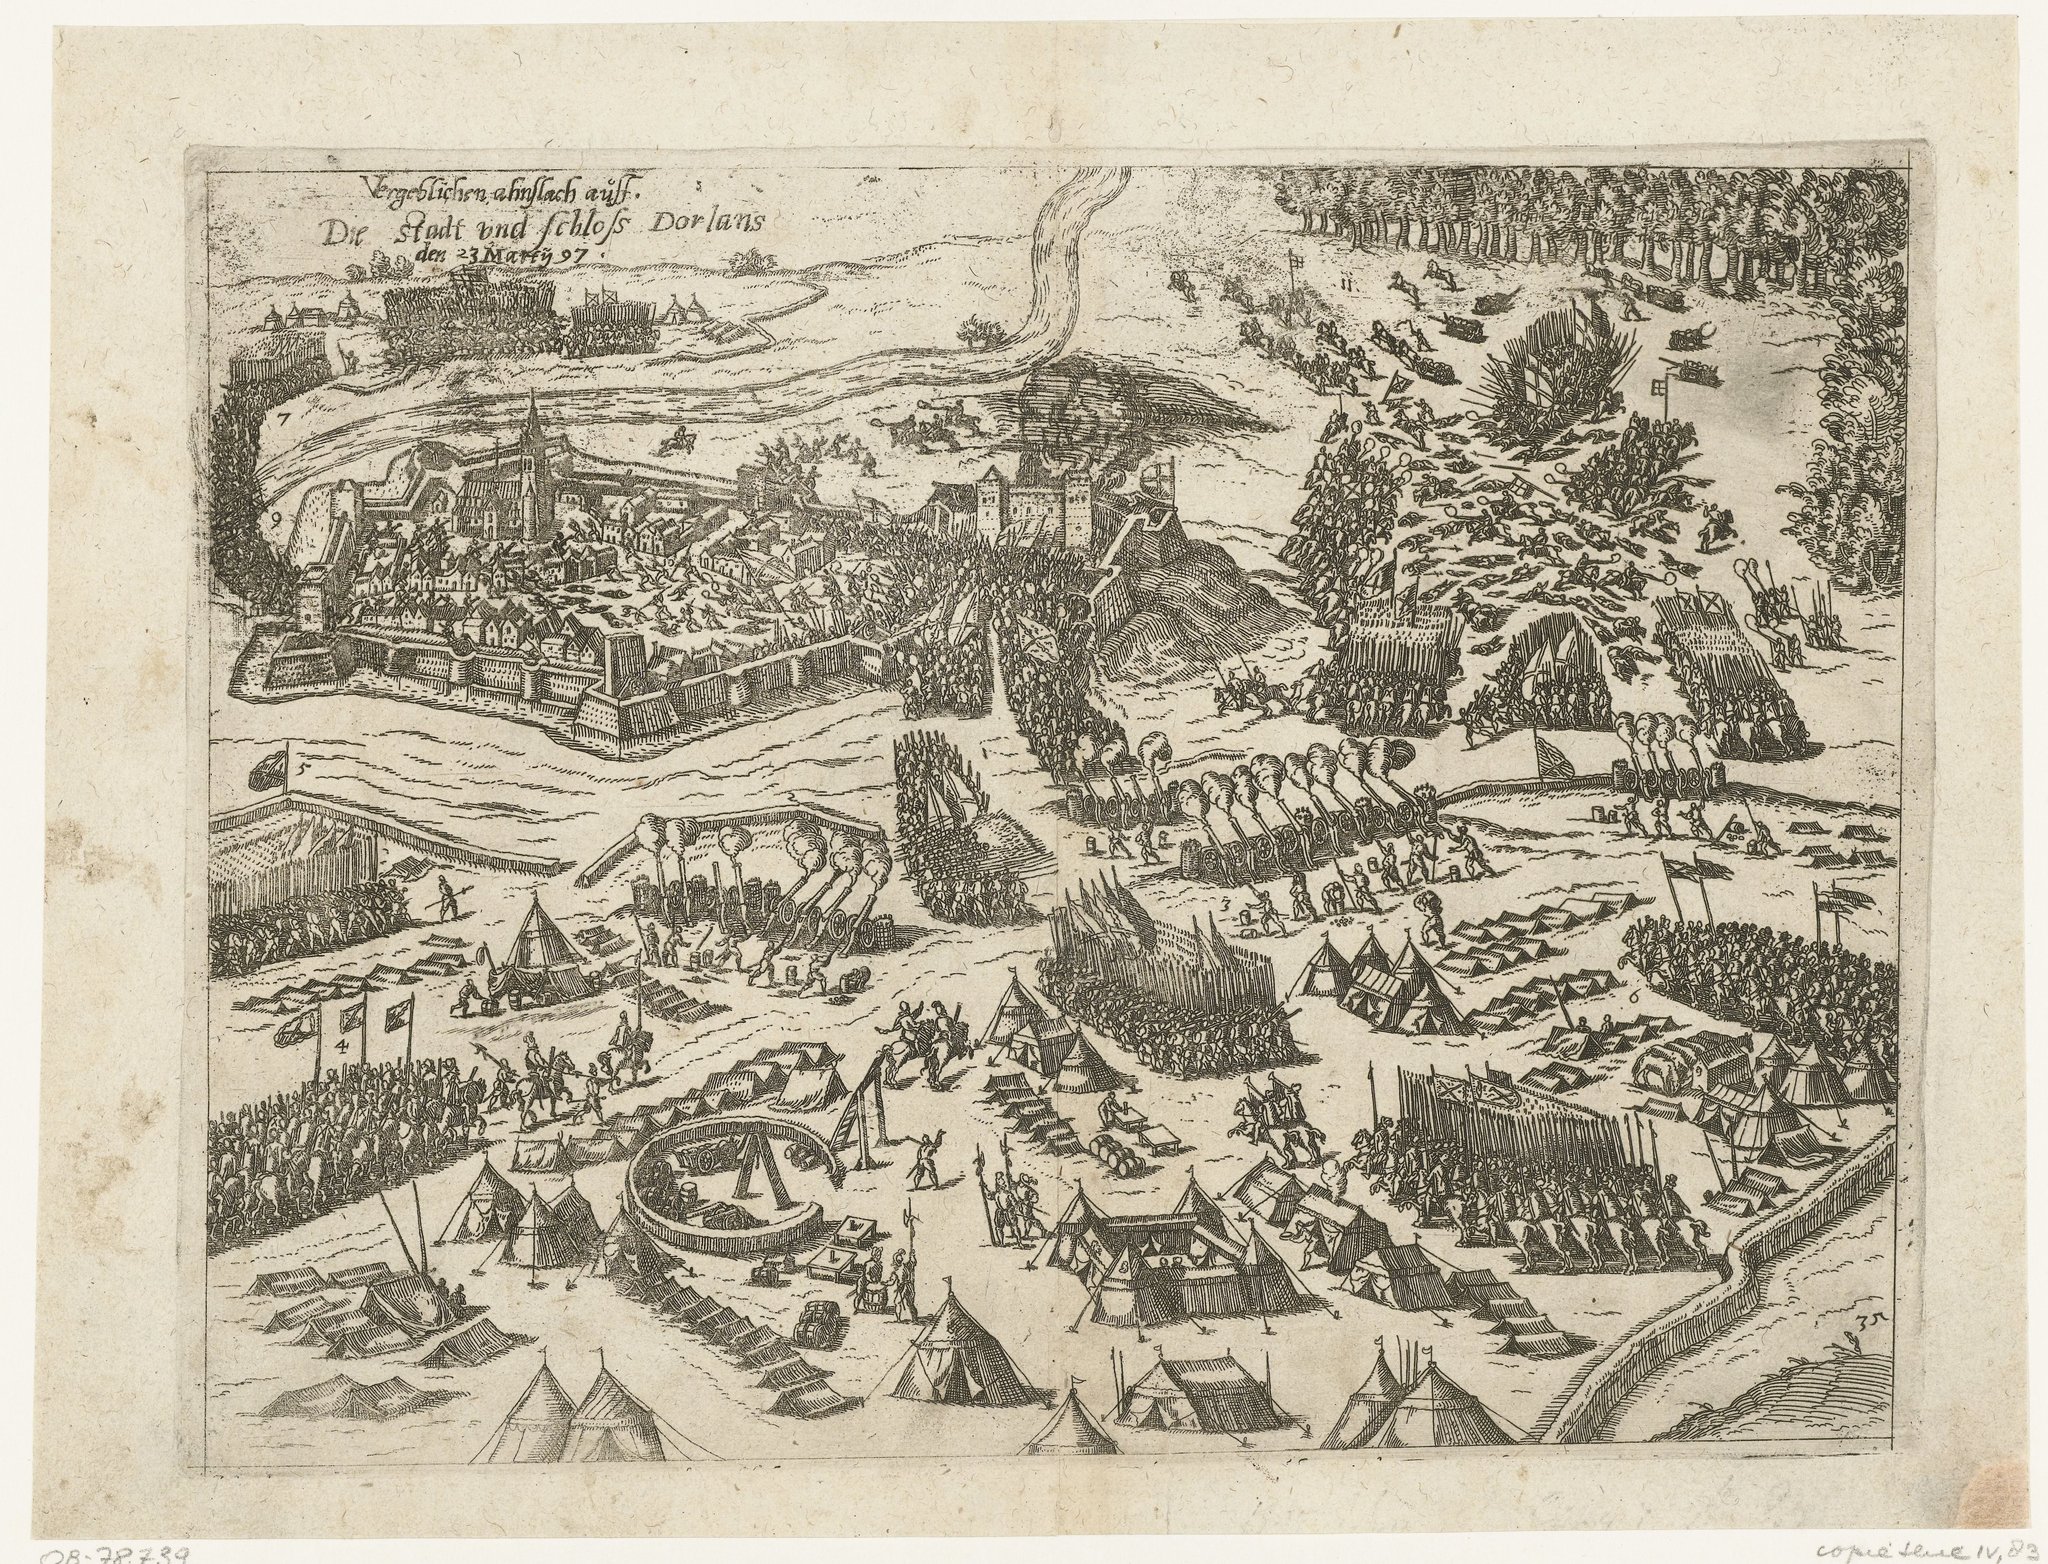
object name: print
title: Aanval op de stad Doullens, 1597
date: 1597-1599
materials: paper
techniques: etching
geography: germany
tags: capture of city (after the siege)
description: Aanval van een leger op de stad Doullens, 23 maart 1597. Op de voorgrond een legerkamp, rechtsboven gevechten. Zonder onderschrift. Ongenummerd. Kopie naar de prent van Hogenberg van de gebeurtenissen op 31 juli 1595.